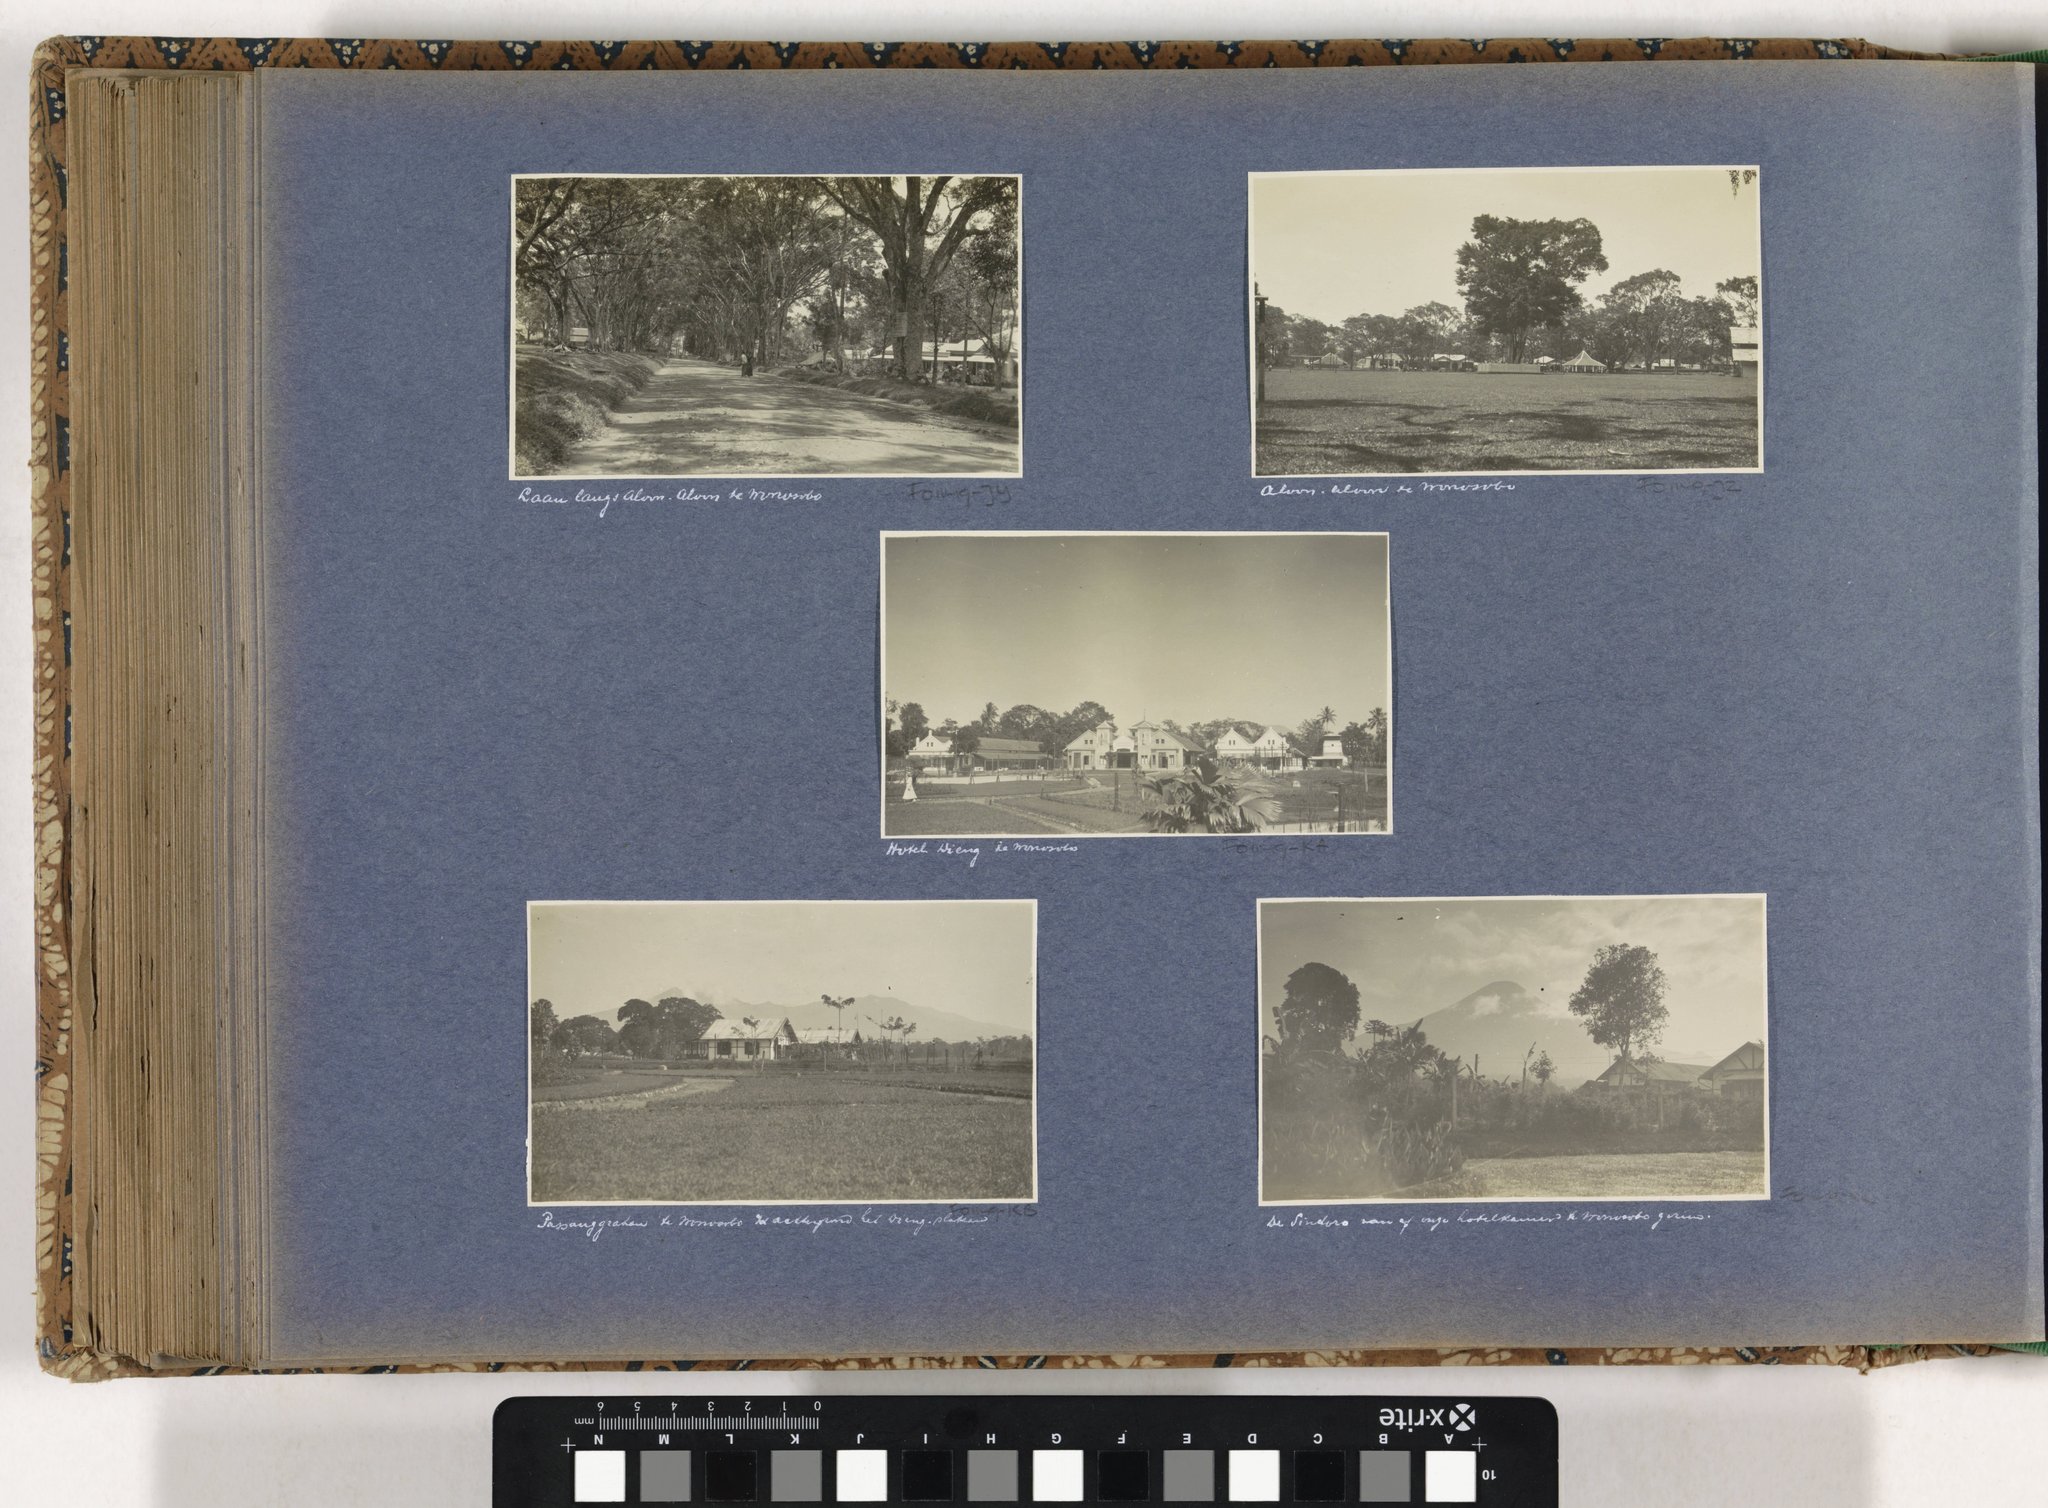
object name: photograph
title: Gezicht op Wonosobo op Java met in het midden Hotel Dieng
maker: Anonymous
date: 1900-1920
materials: paper, photographic support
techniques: gelatin silver print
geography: java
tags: prospect of village, silhouette of village, hotel, hostelry, inn, java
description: Onderdeel van reisalbum met foto's van bedrijvigheid en bezienswaardigheden op Sumatra en Java en van de reis naar en van Nederlands-Indië.